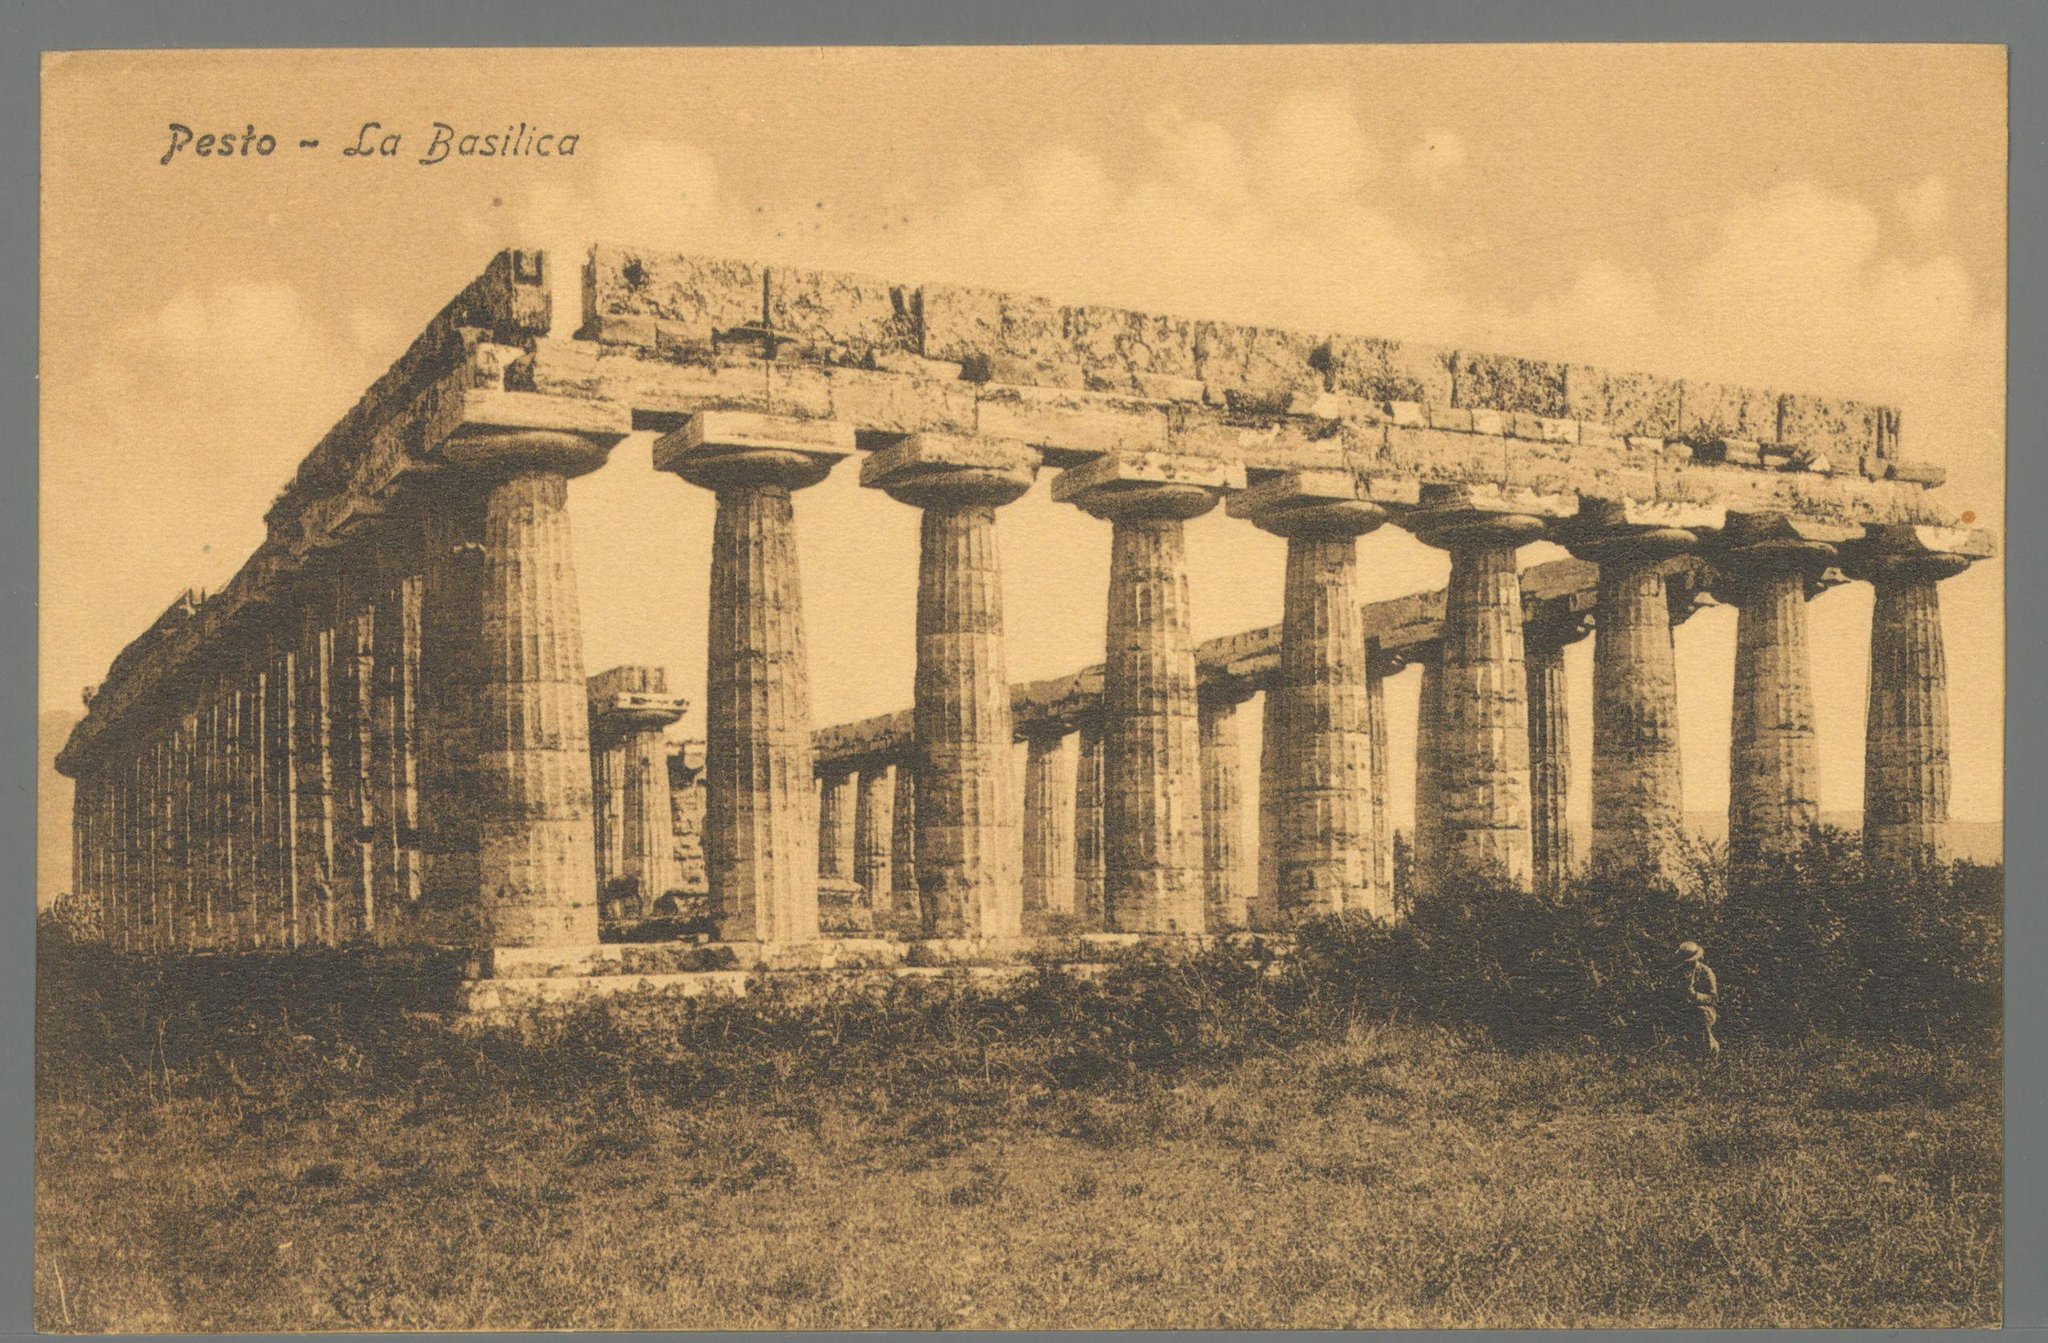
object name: photomechanical print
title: Pesto. La Basilica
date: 1906-1930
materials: cardboard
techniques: photograph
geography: paestum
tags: column, pillar ~ architecture, temple, shrine ~ roman religion